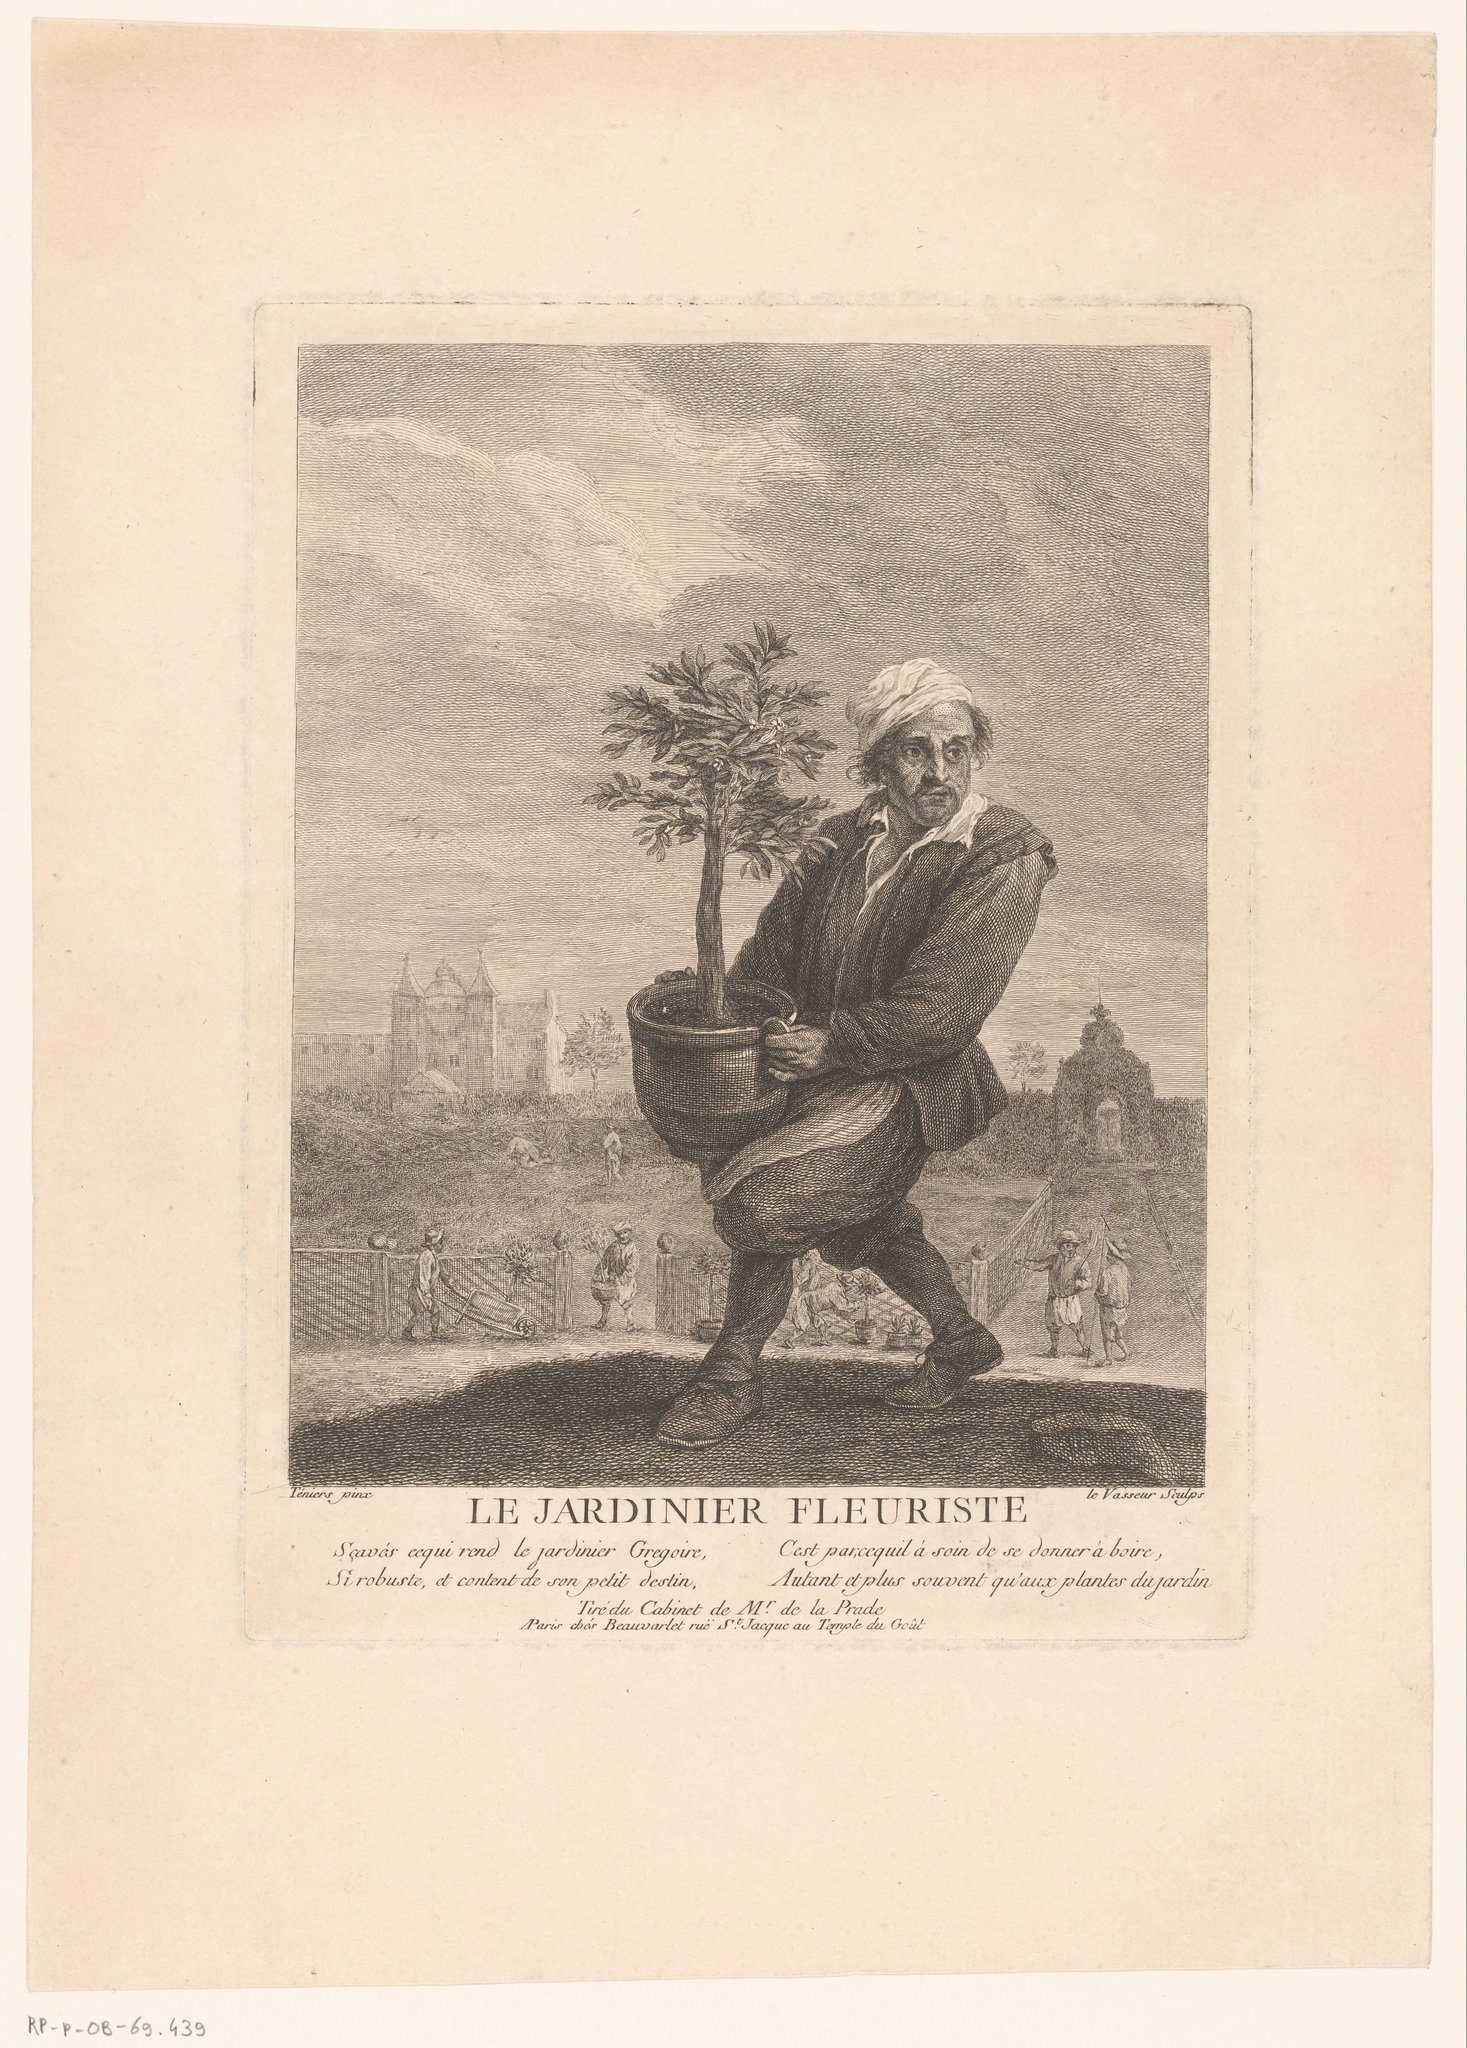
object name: print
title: Le Jardinier Fleuriste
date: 1744-1797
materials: paper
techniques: engraving, etching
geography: paris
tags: gardening, potted plants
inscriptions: collector's mark: Lugt 2228